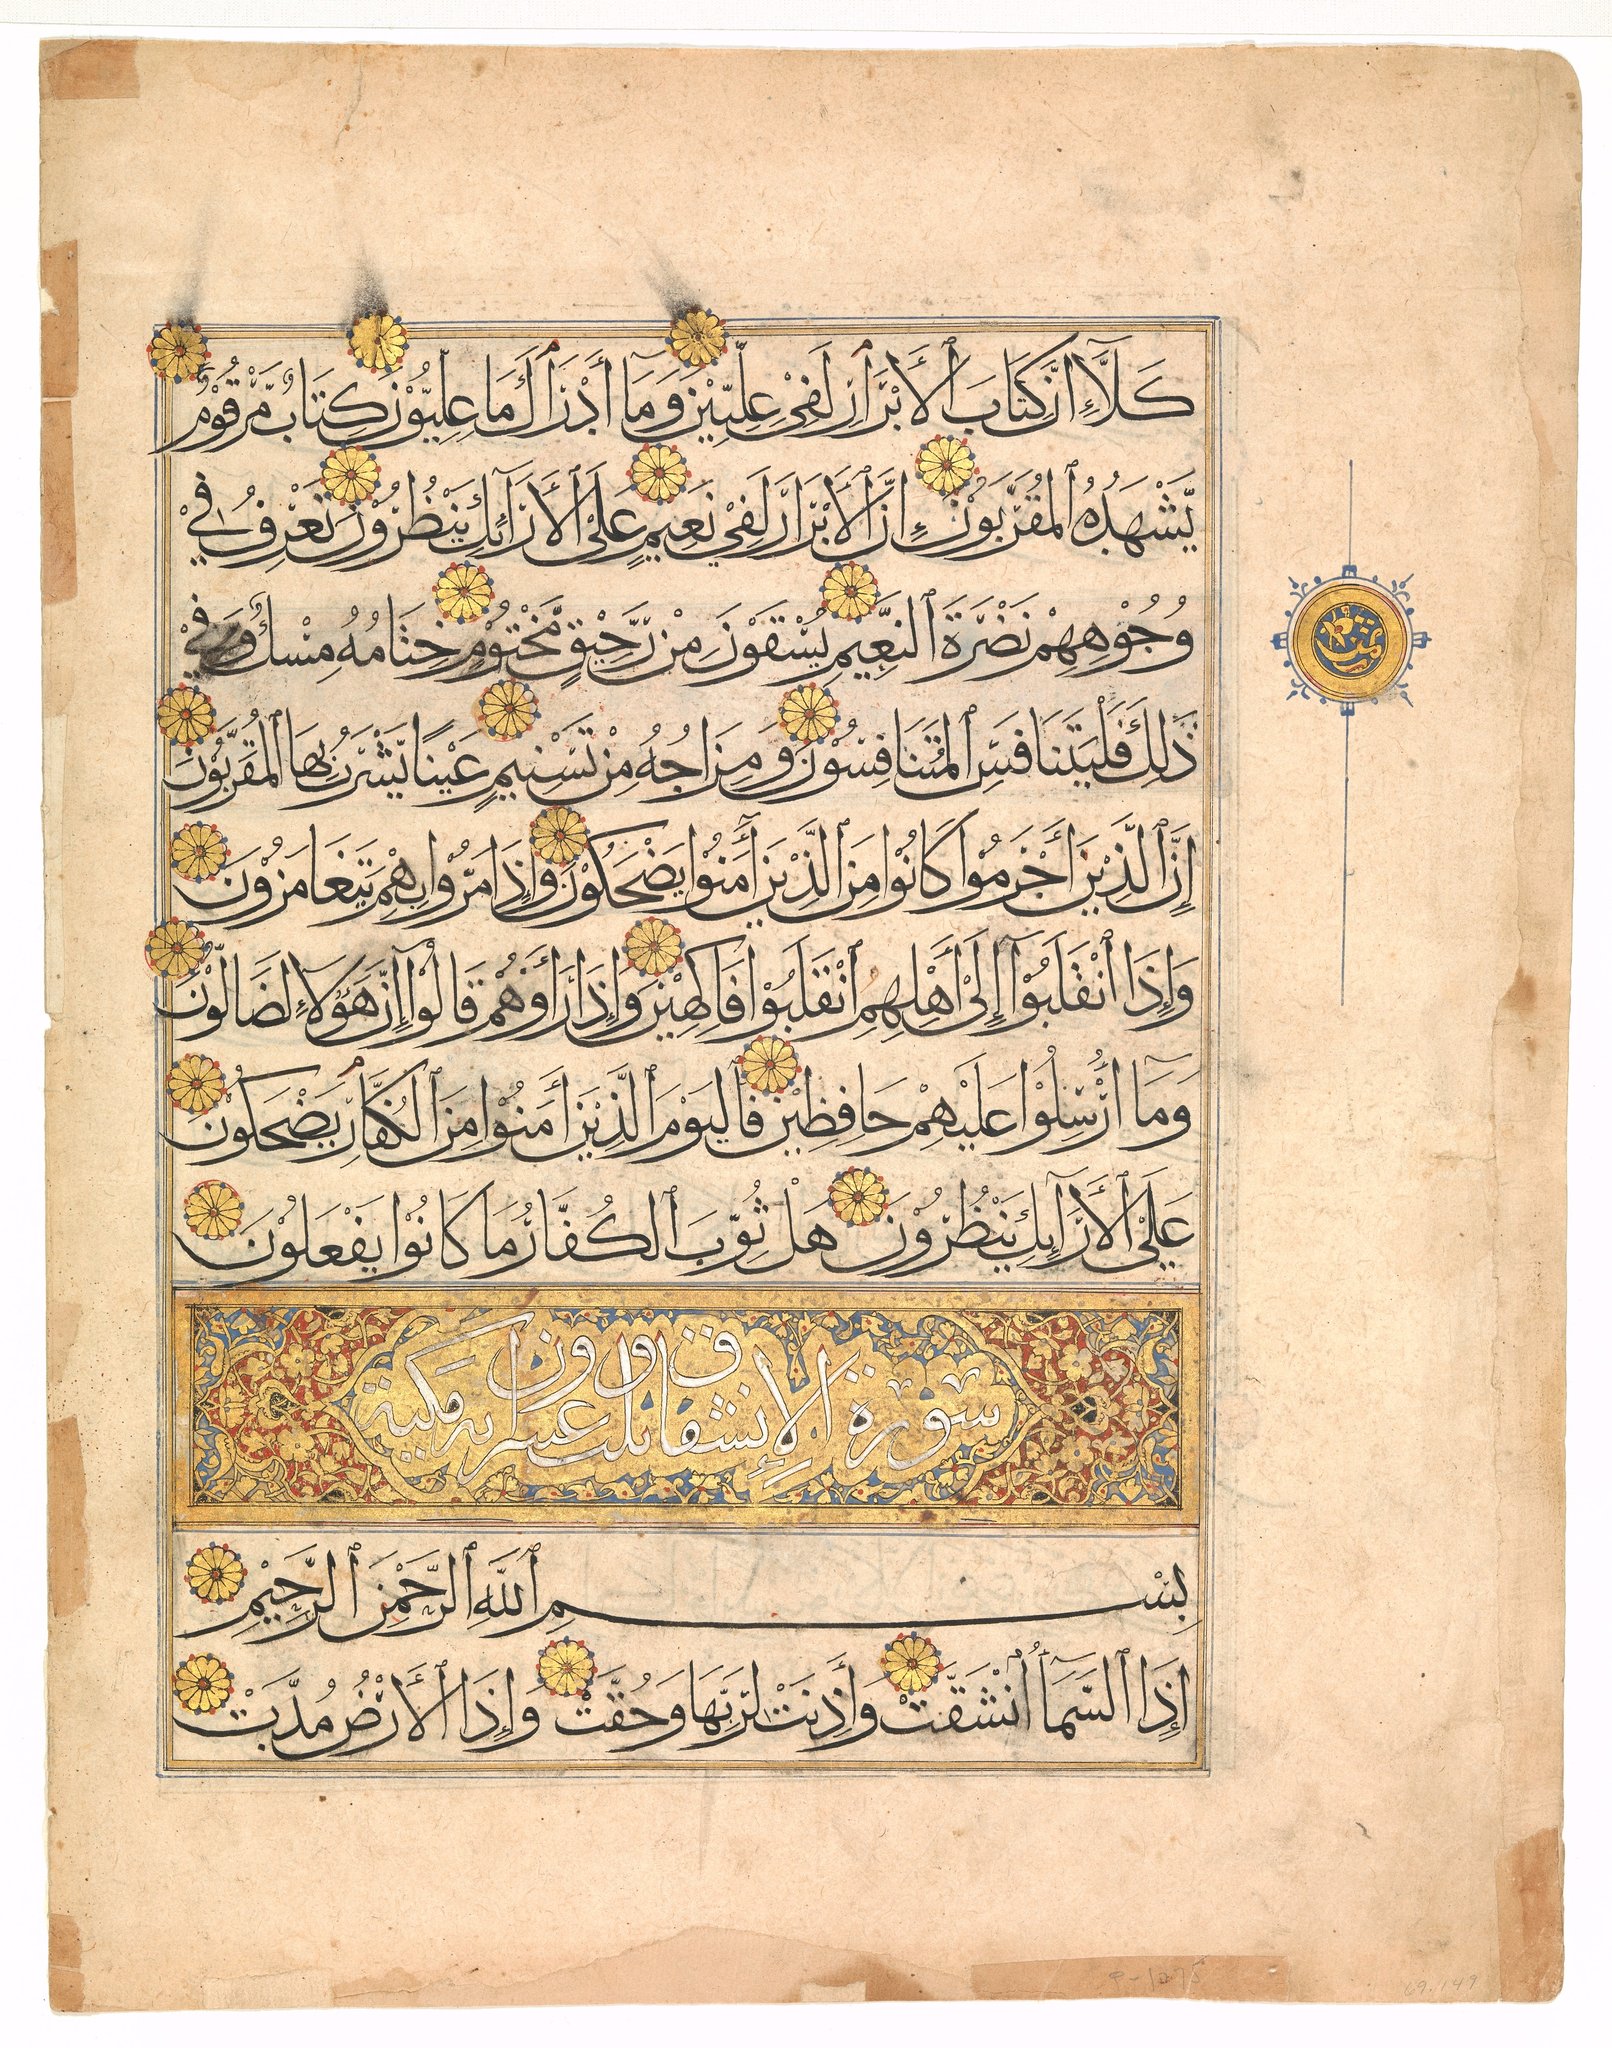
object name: folio from a non illustrated manuscript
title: Folio from a Qur'an Manuscript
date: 1301-1400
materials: gold, ink, paper, watercolor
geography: egypt or syria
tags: qur'an,calligraphy